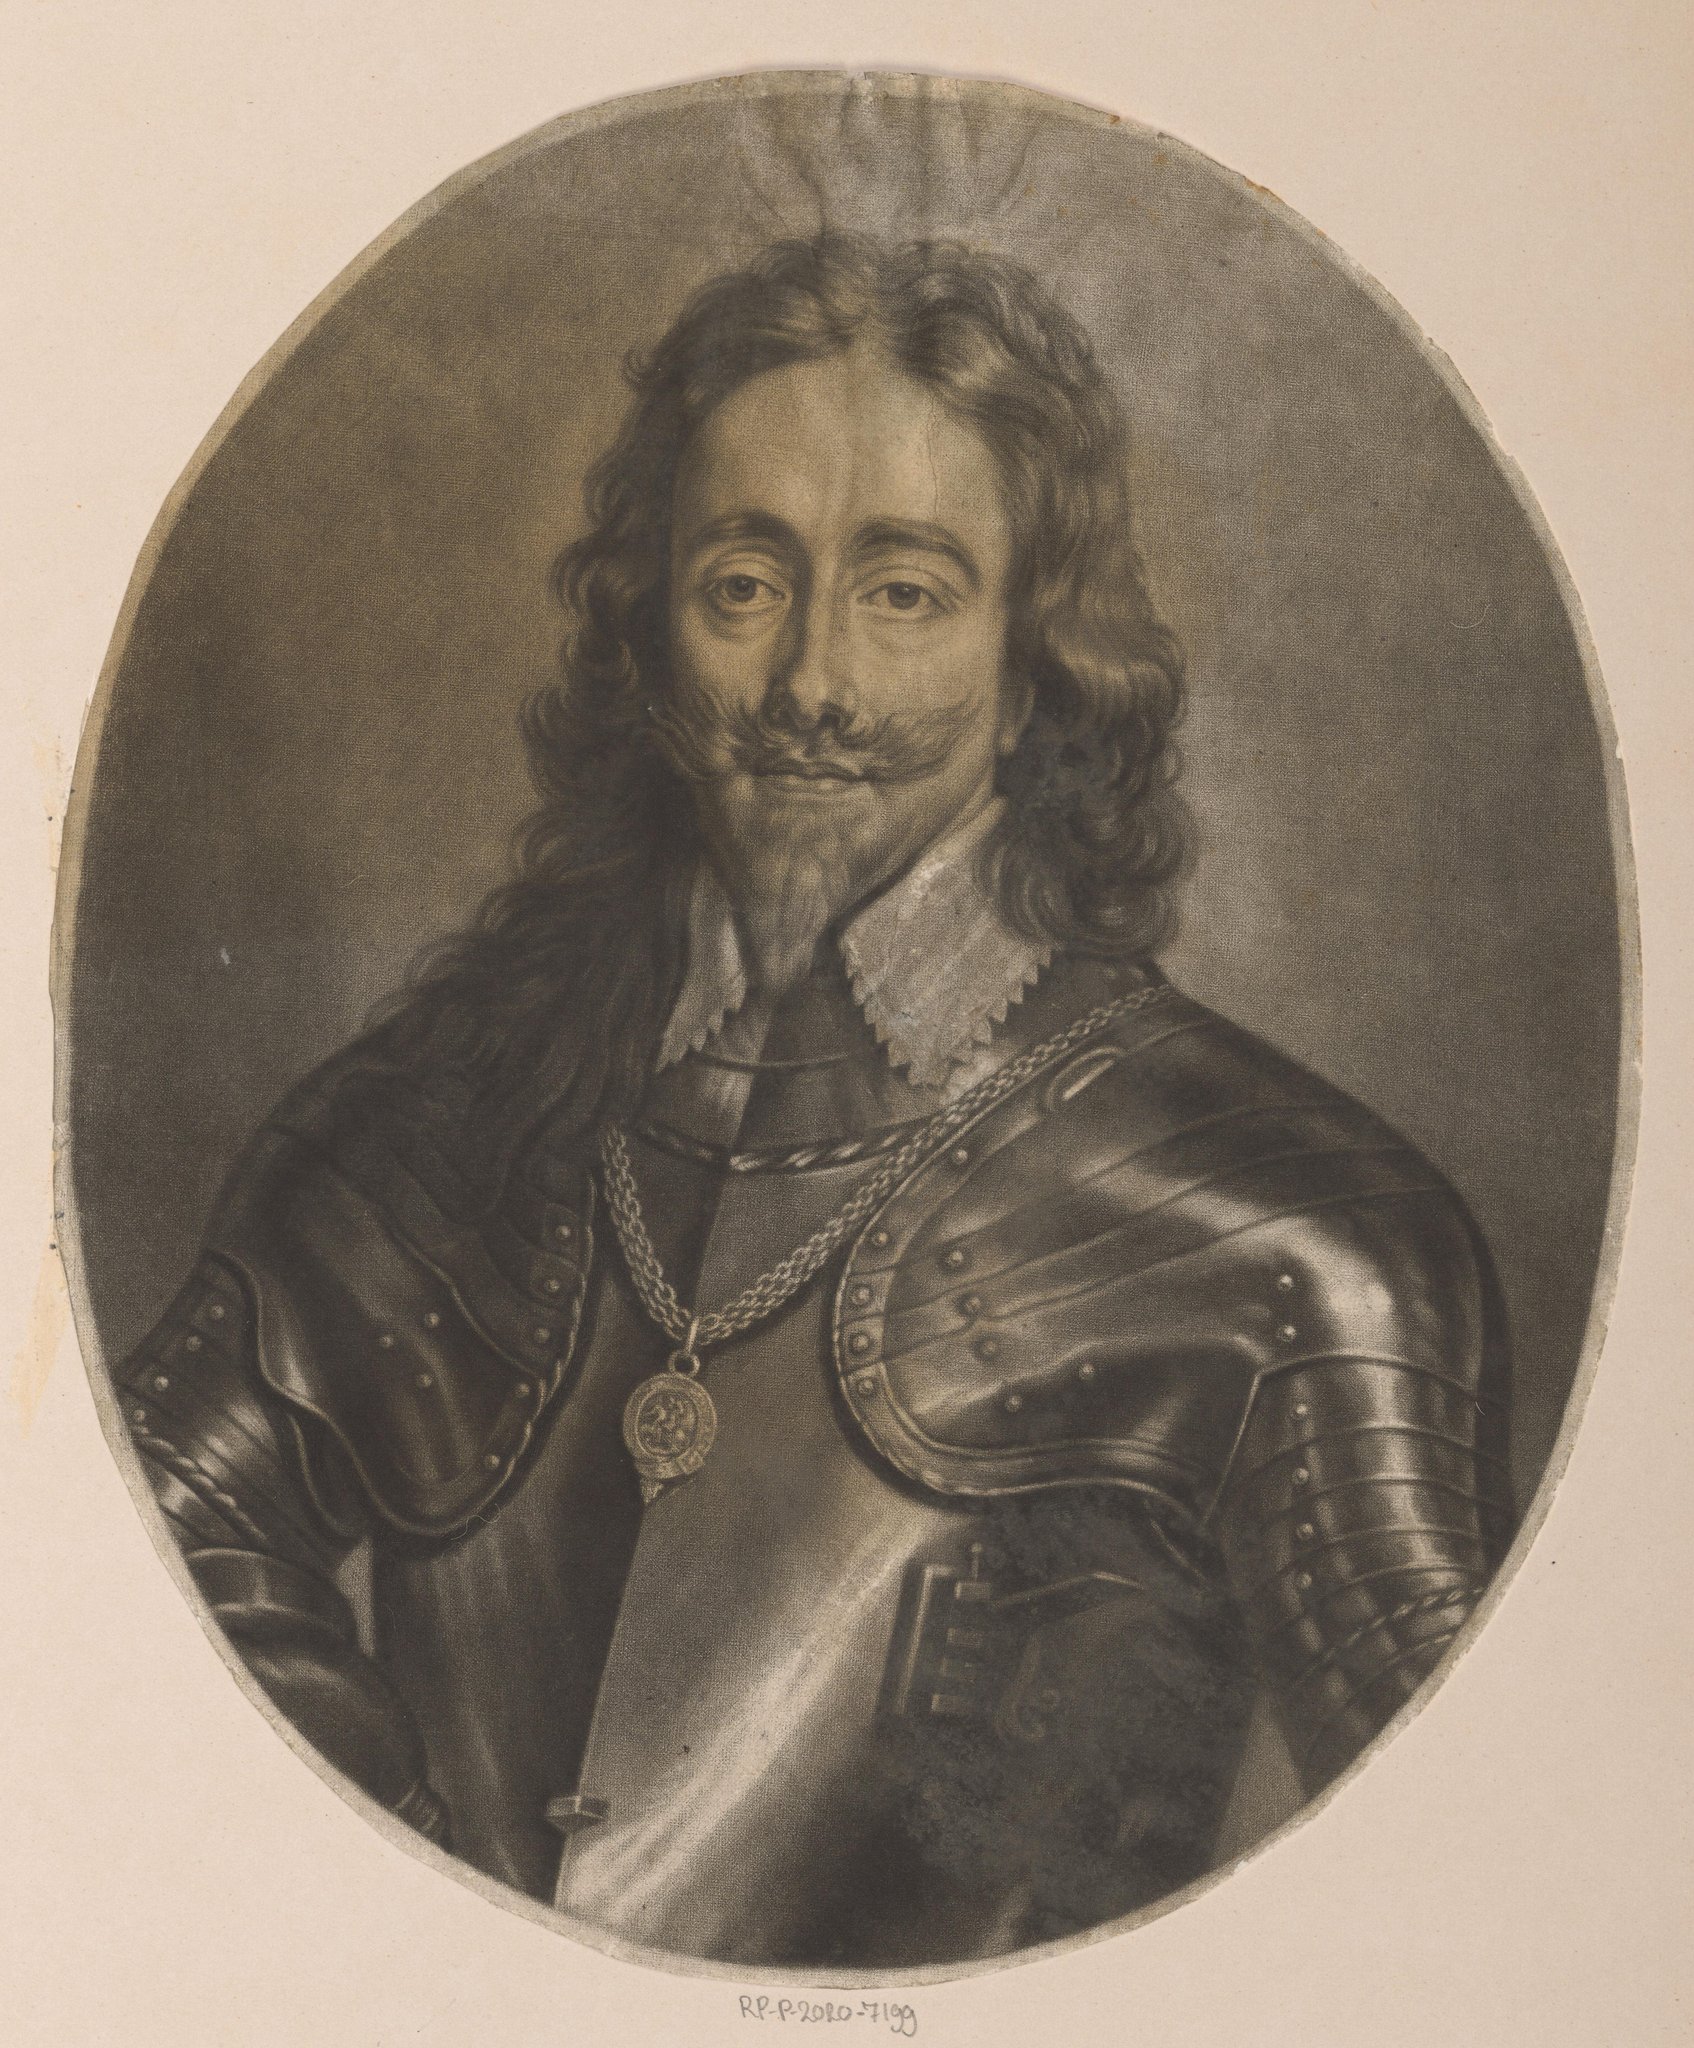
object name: print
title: Portret van Karel I, koning van Engeland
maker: isaac beckett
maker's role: print maker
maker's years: 1653-1719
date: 1663-1715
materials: paper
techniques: mezzotint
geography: london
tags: london, karel i (koning van engeland), knighthood order, historical persons, king